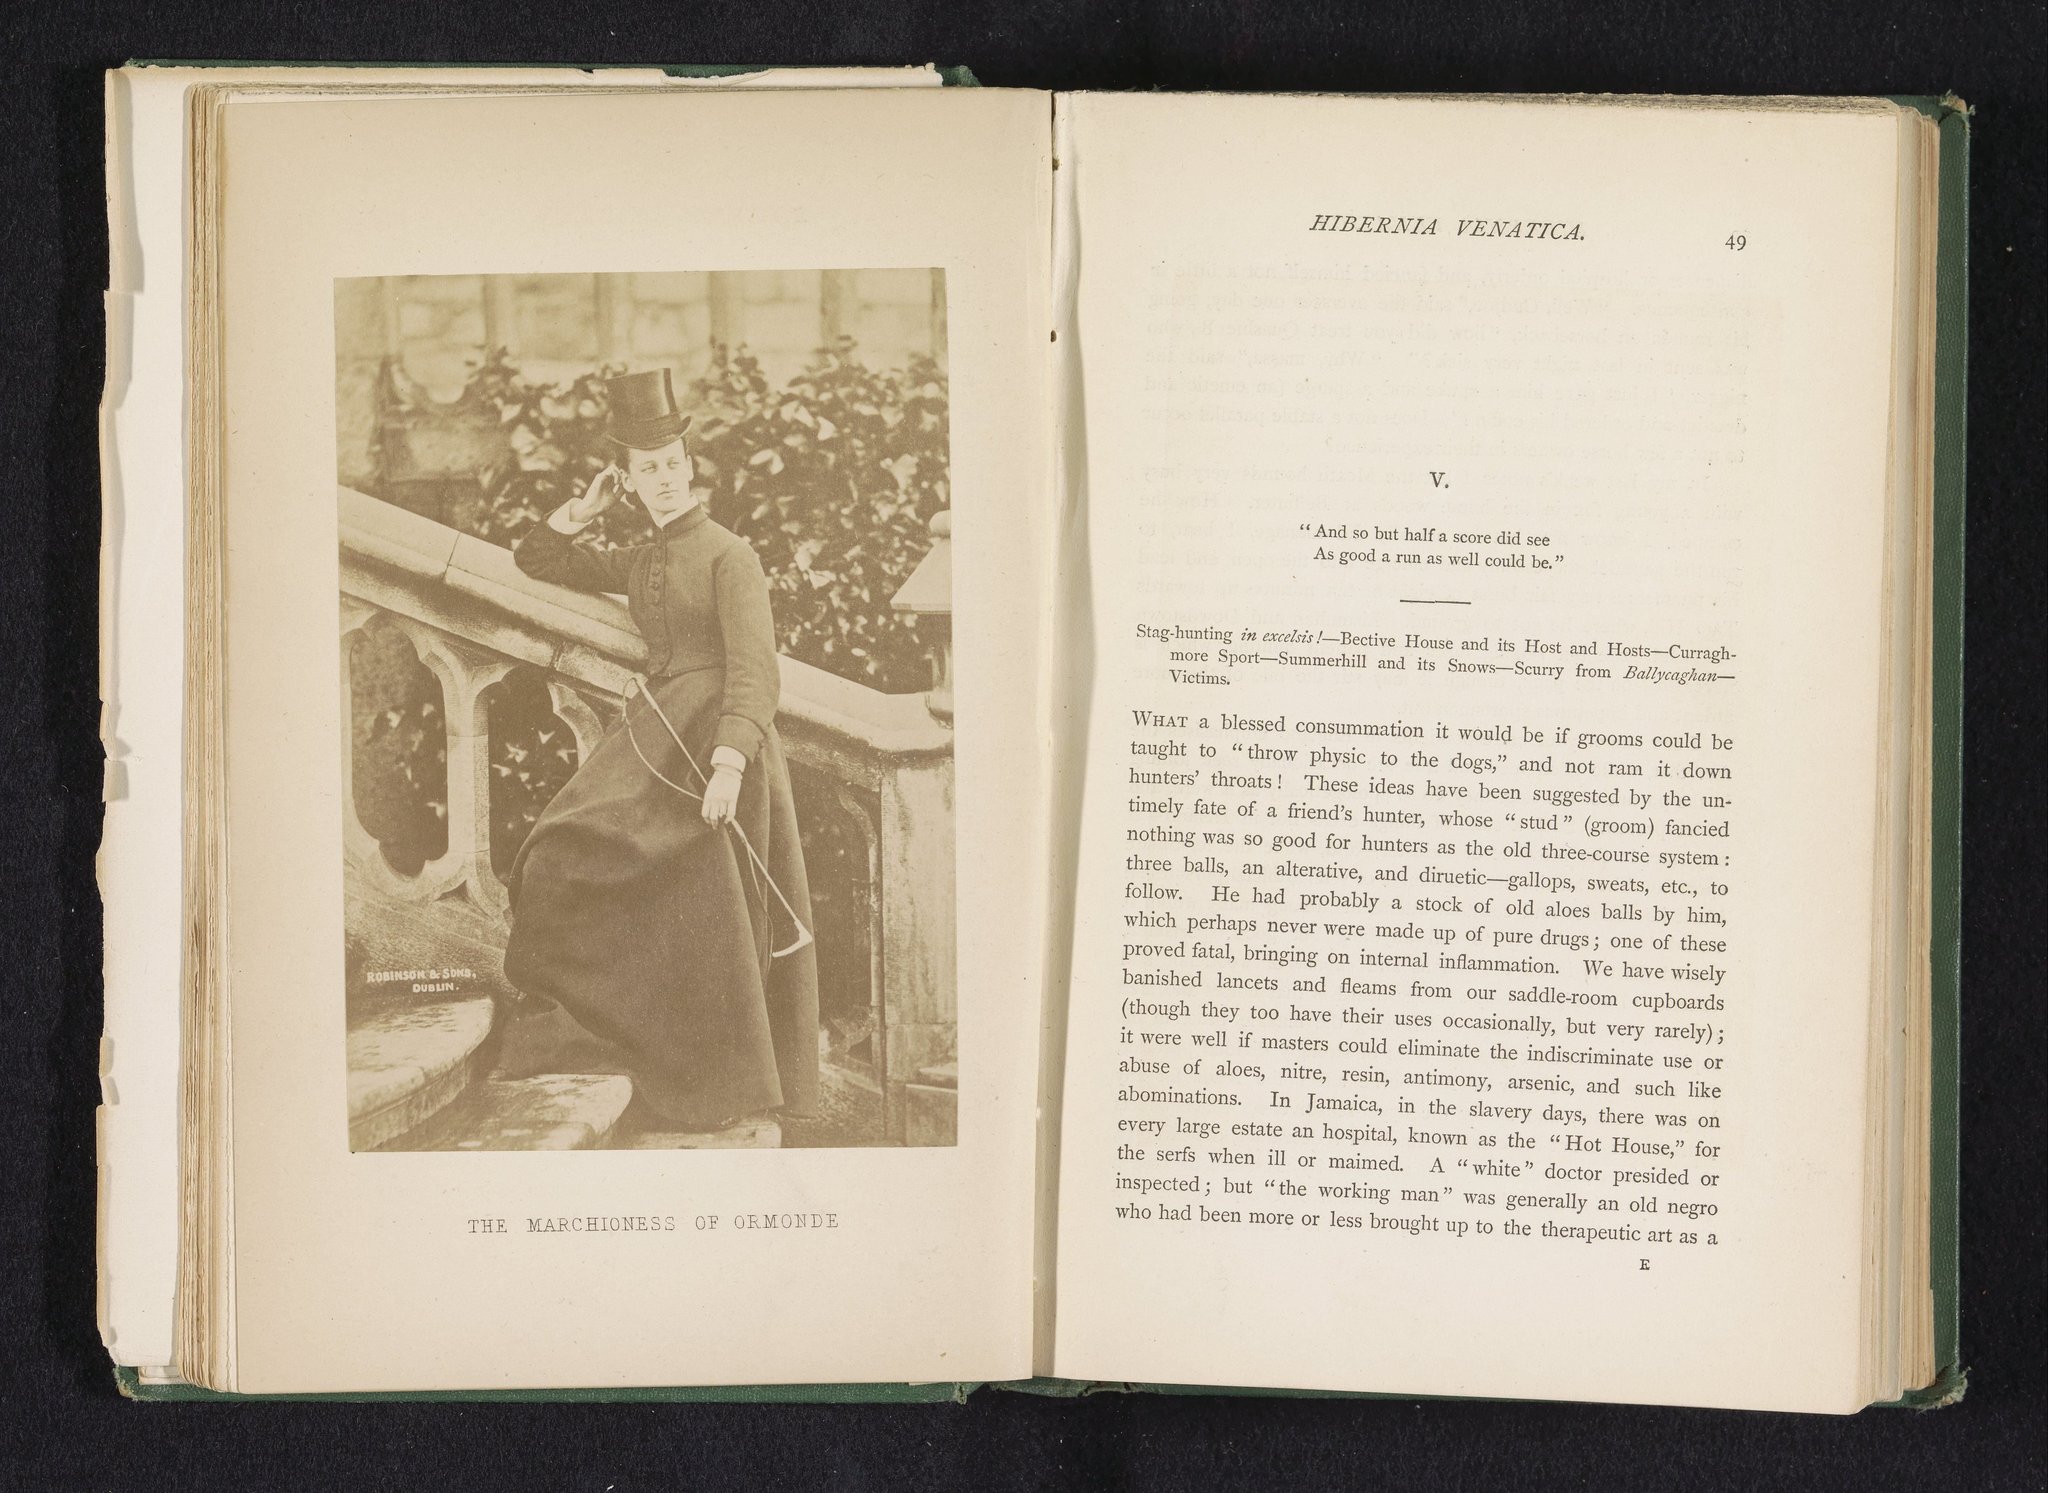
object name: page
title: The Marchioness of Ormonde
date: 1850-1878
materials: photographic support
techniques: albumen print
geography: ireland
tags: riding a horse, ass, or mule; rider, horseman, adult woman, nobility and patriciate; chivalry, knighthood, whip